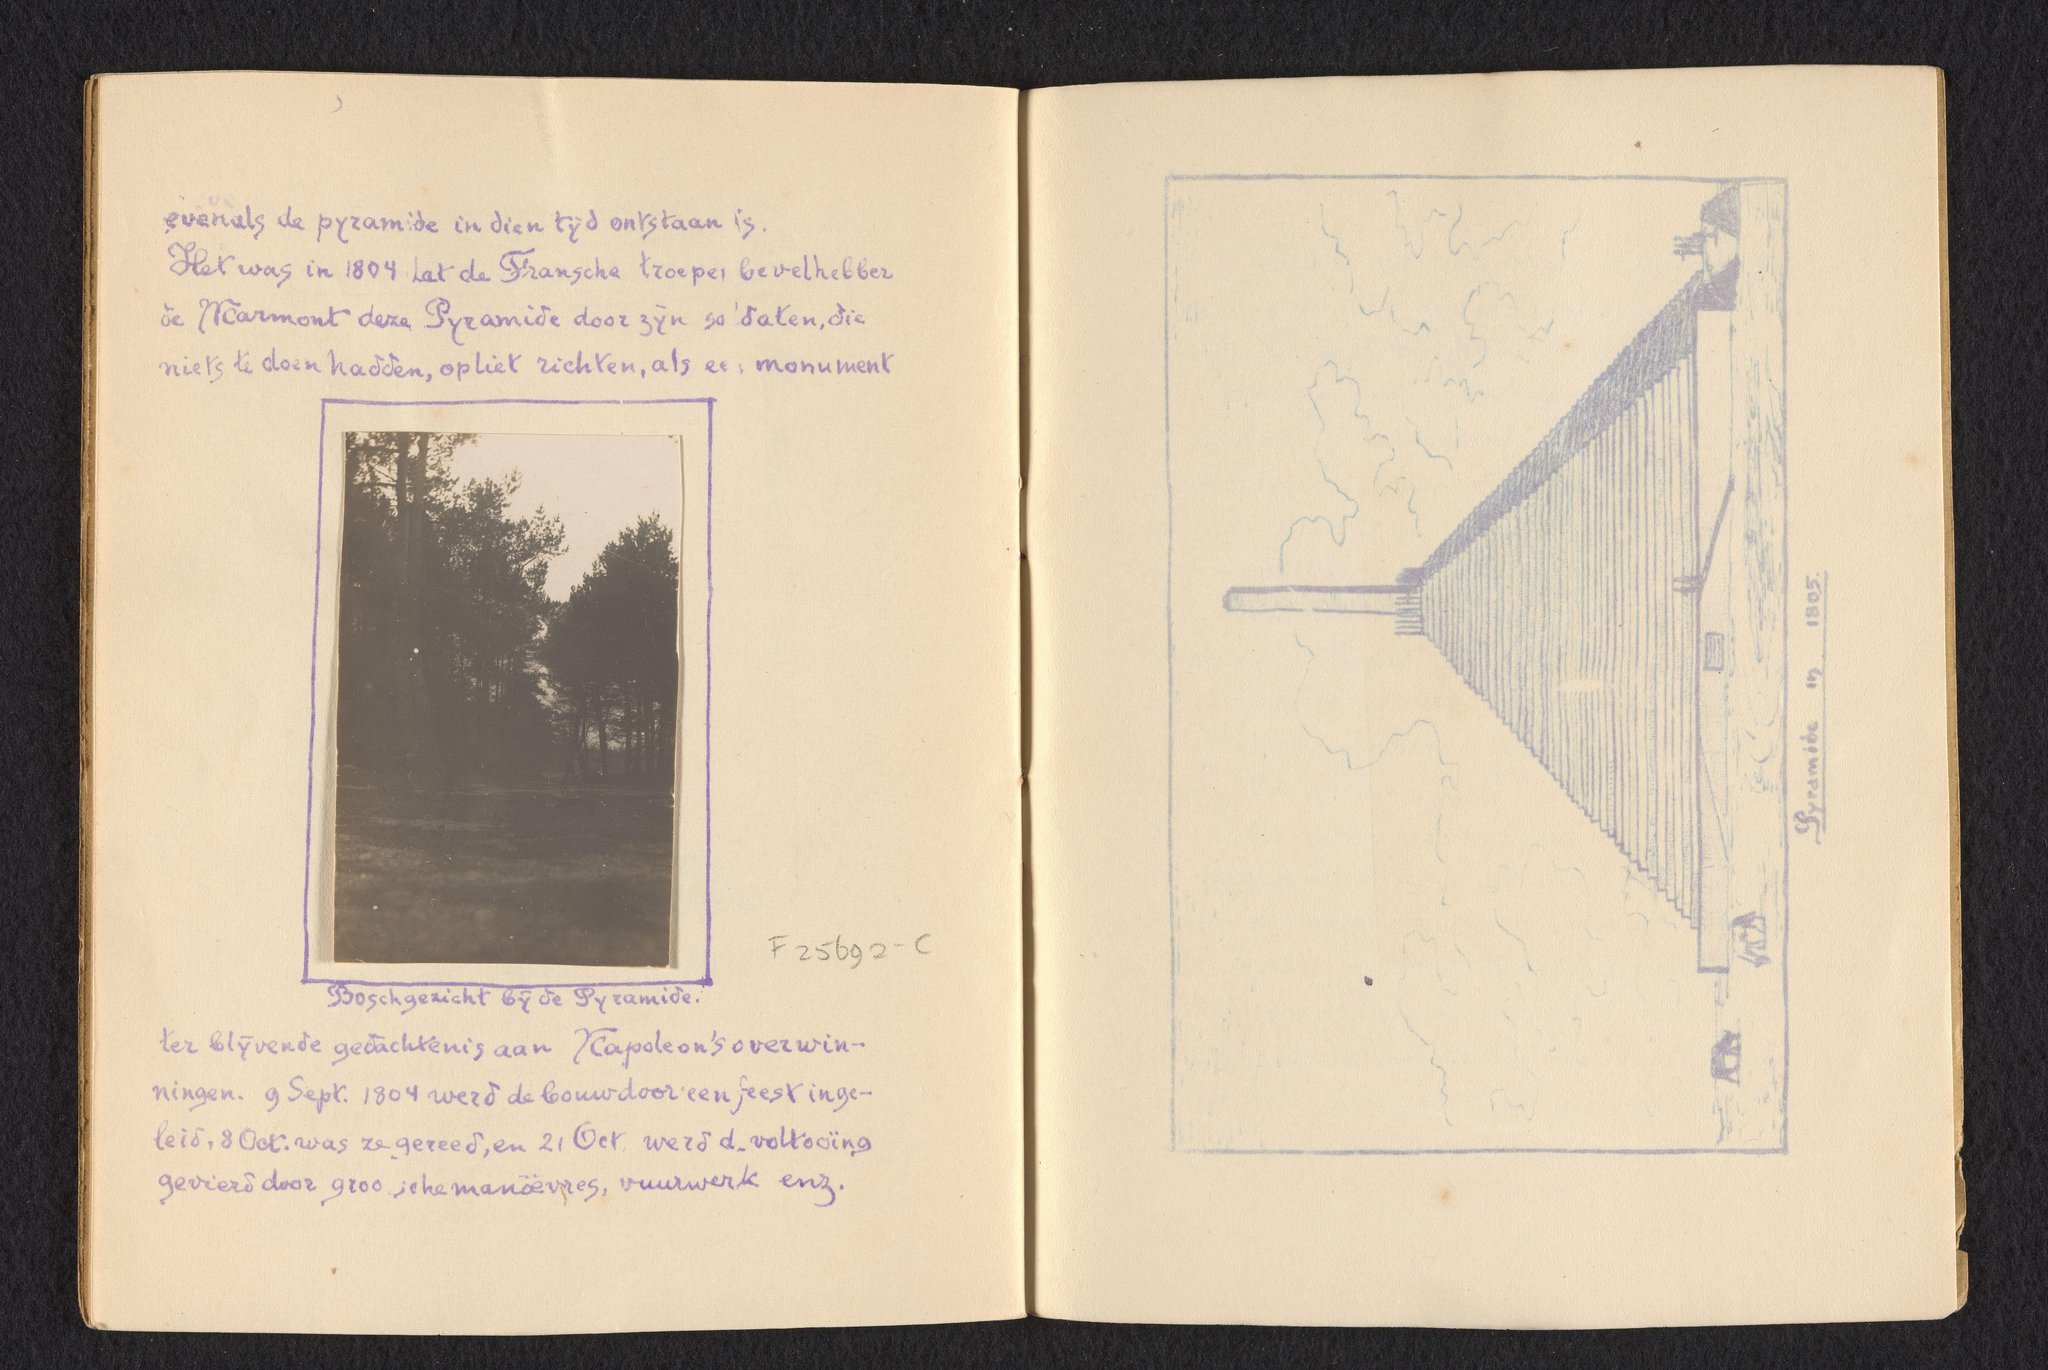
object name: page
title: Boschgezicht bij de Pyramide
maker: Anonymous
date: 1912-1917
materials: paper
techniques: gelatin silver print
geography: woudenberg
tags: forest, wood